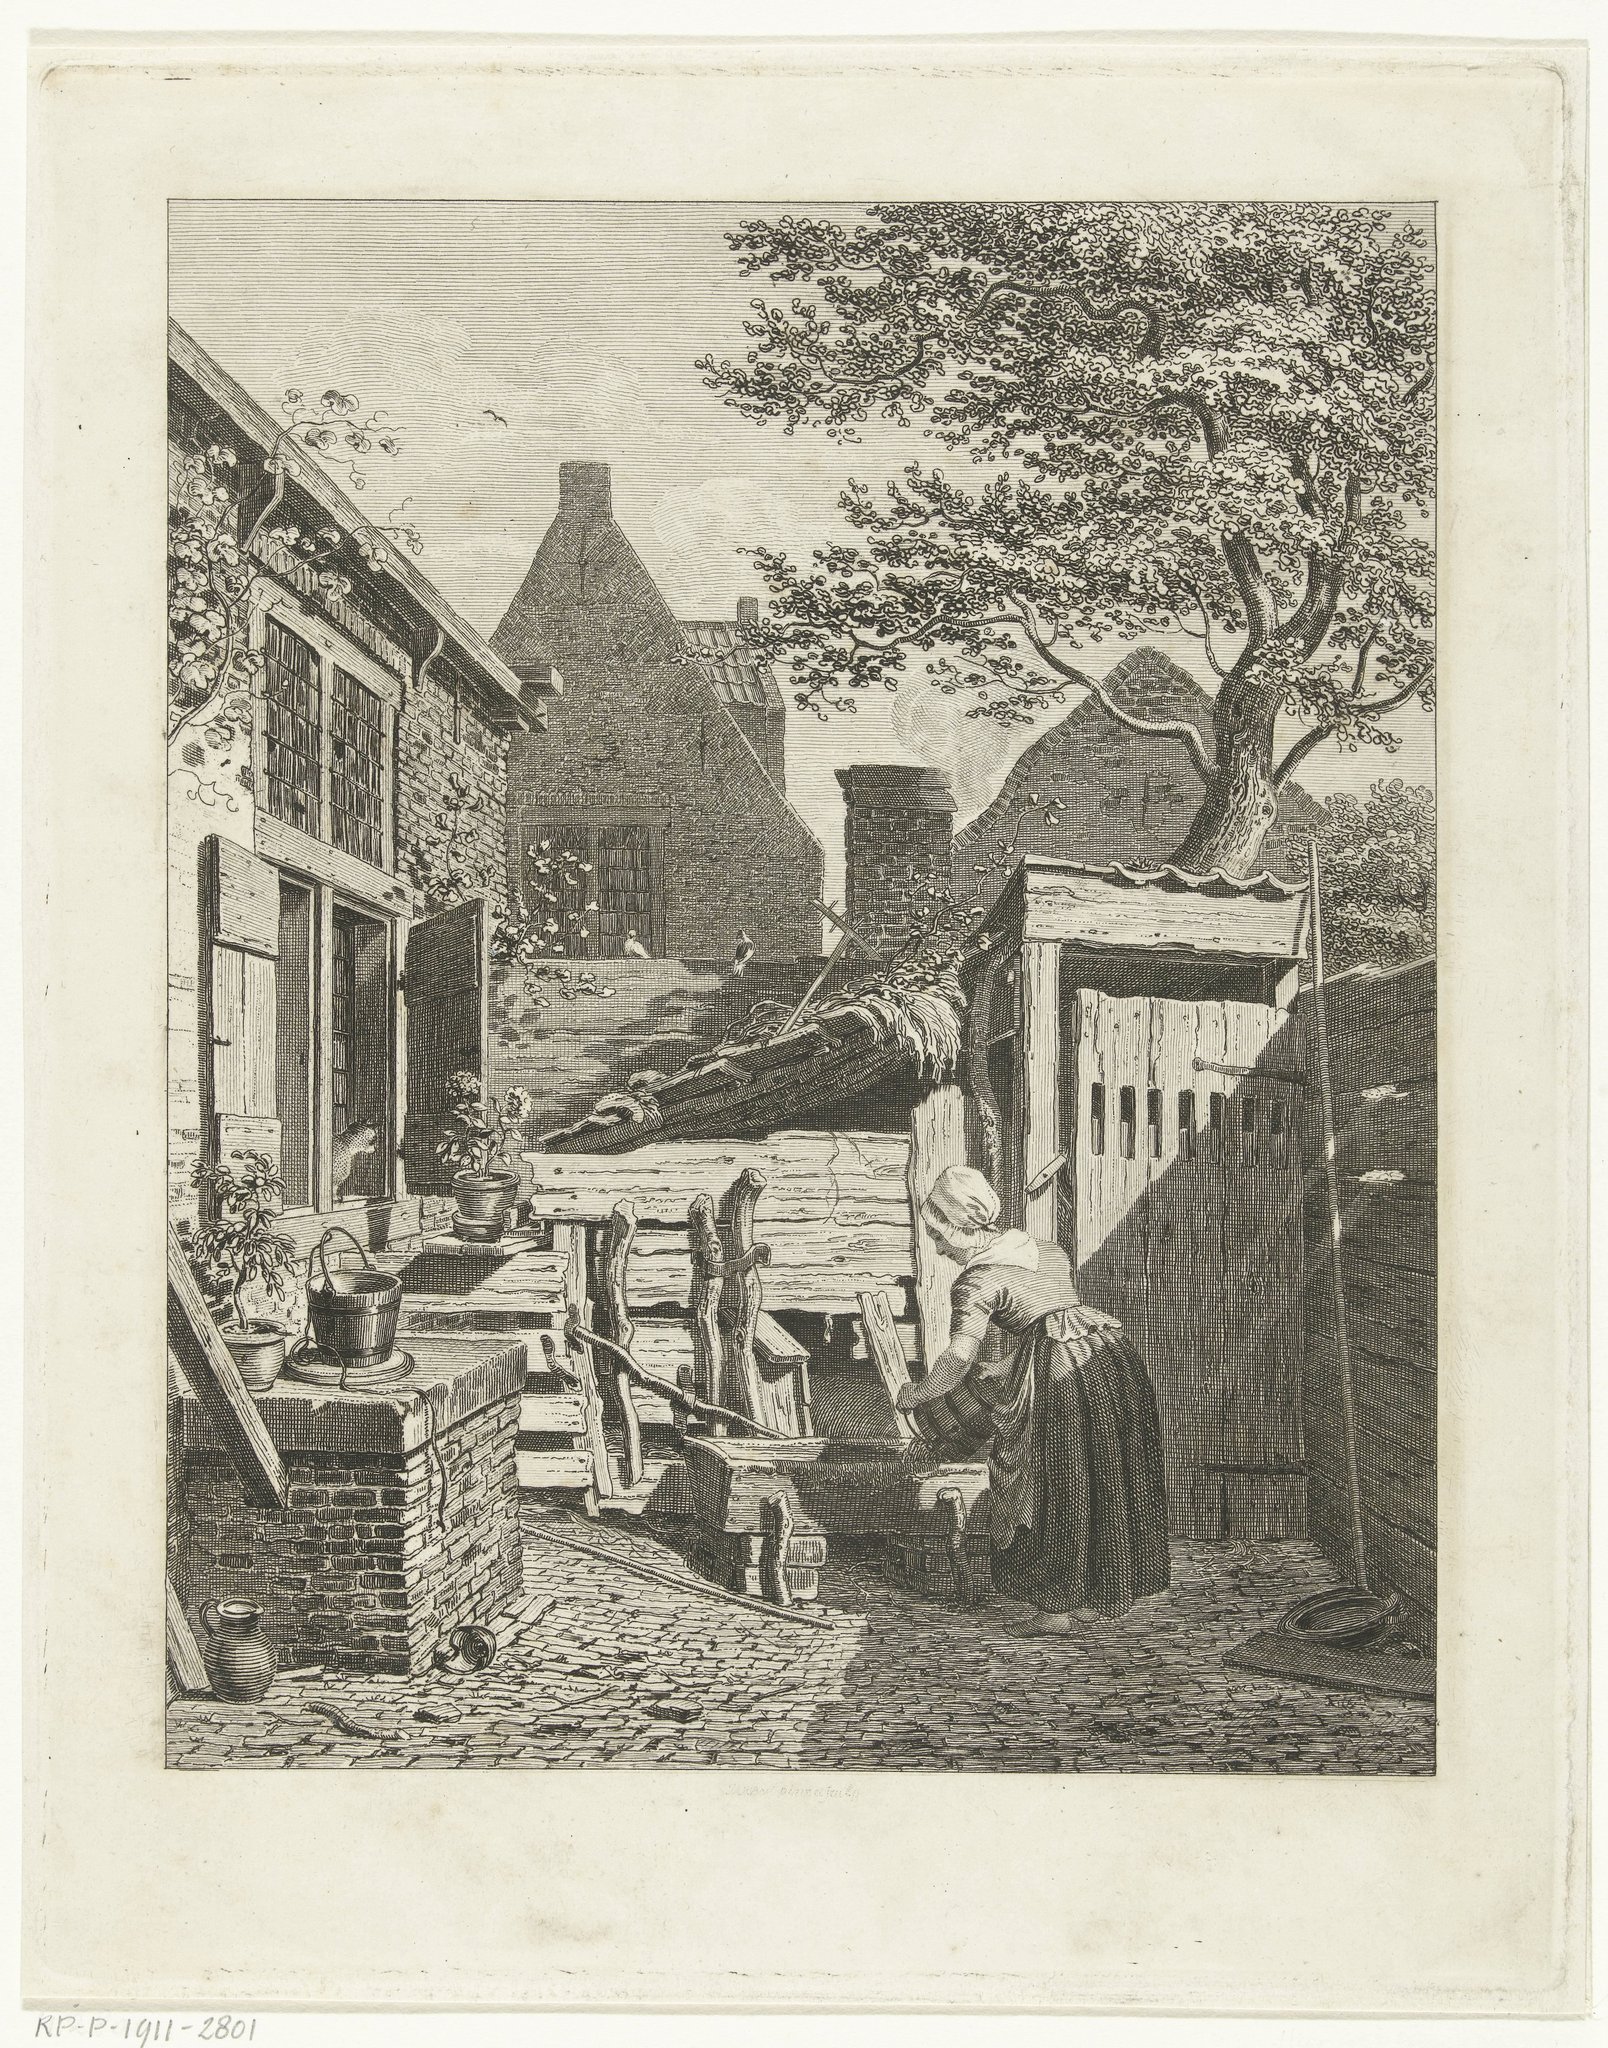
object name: print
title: Binnenplaats met vrouw die trog vult bij hok van dier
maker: johannes alexander rudolf best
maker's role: print maker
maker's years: 1797-1855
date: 1807-1855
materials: paper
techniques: etching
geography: amsterdam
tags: façade of inner court, giving water, feeding (cattle)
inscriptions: collector's mark: Lugt 2228